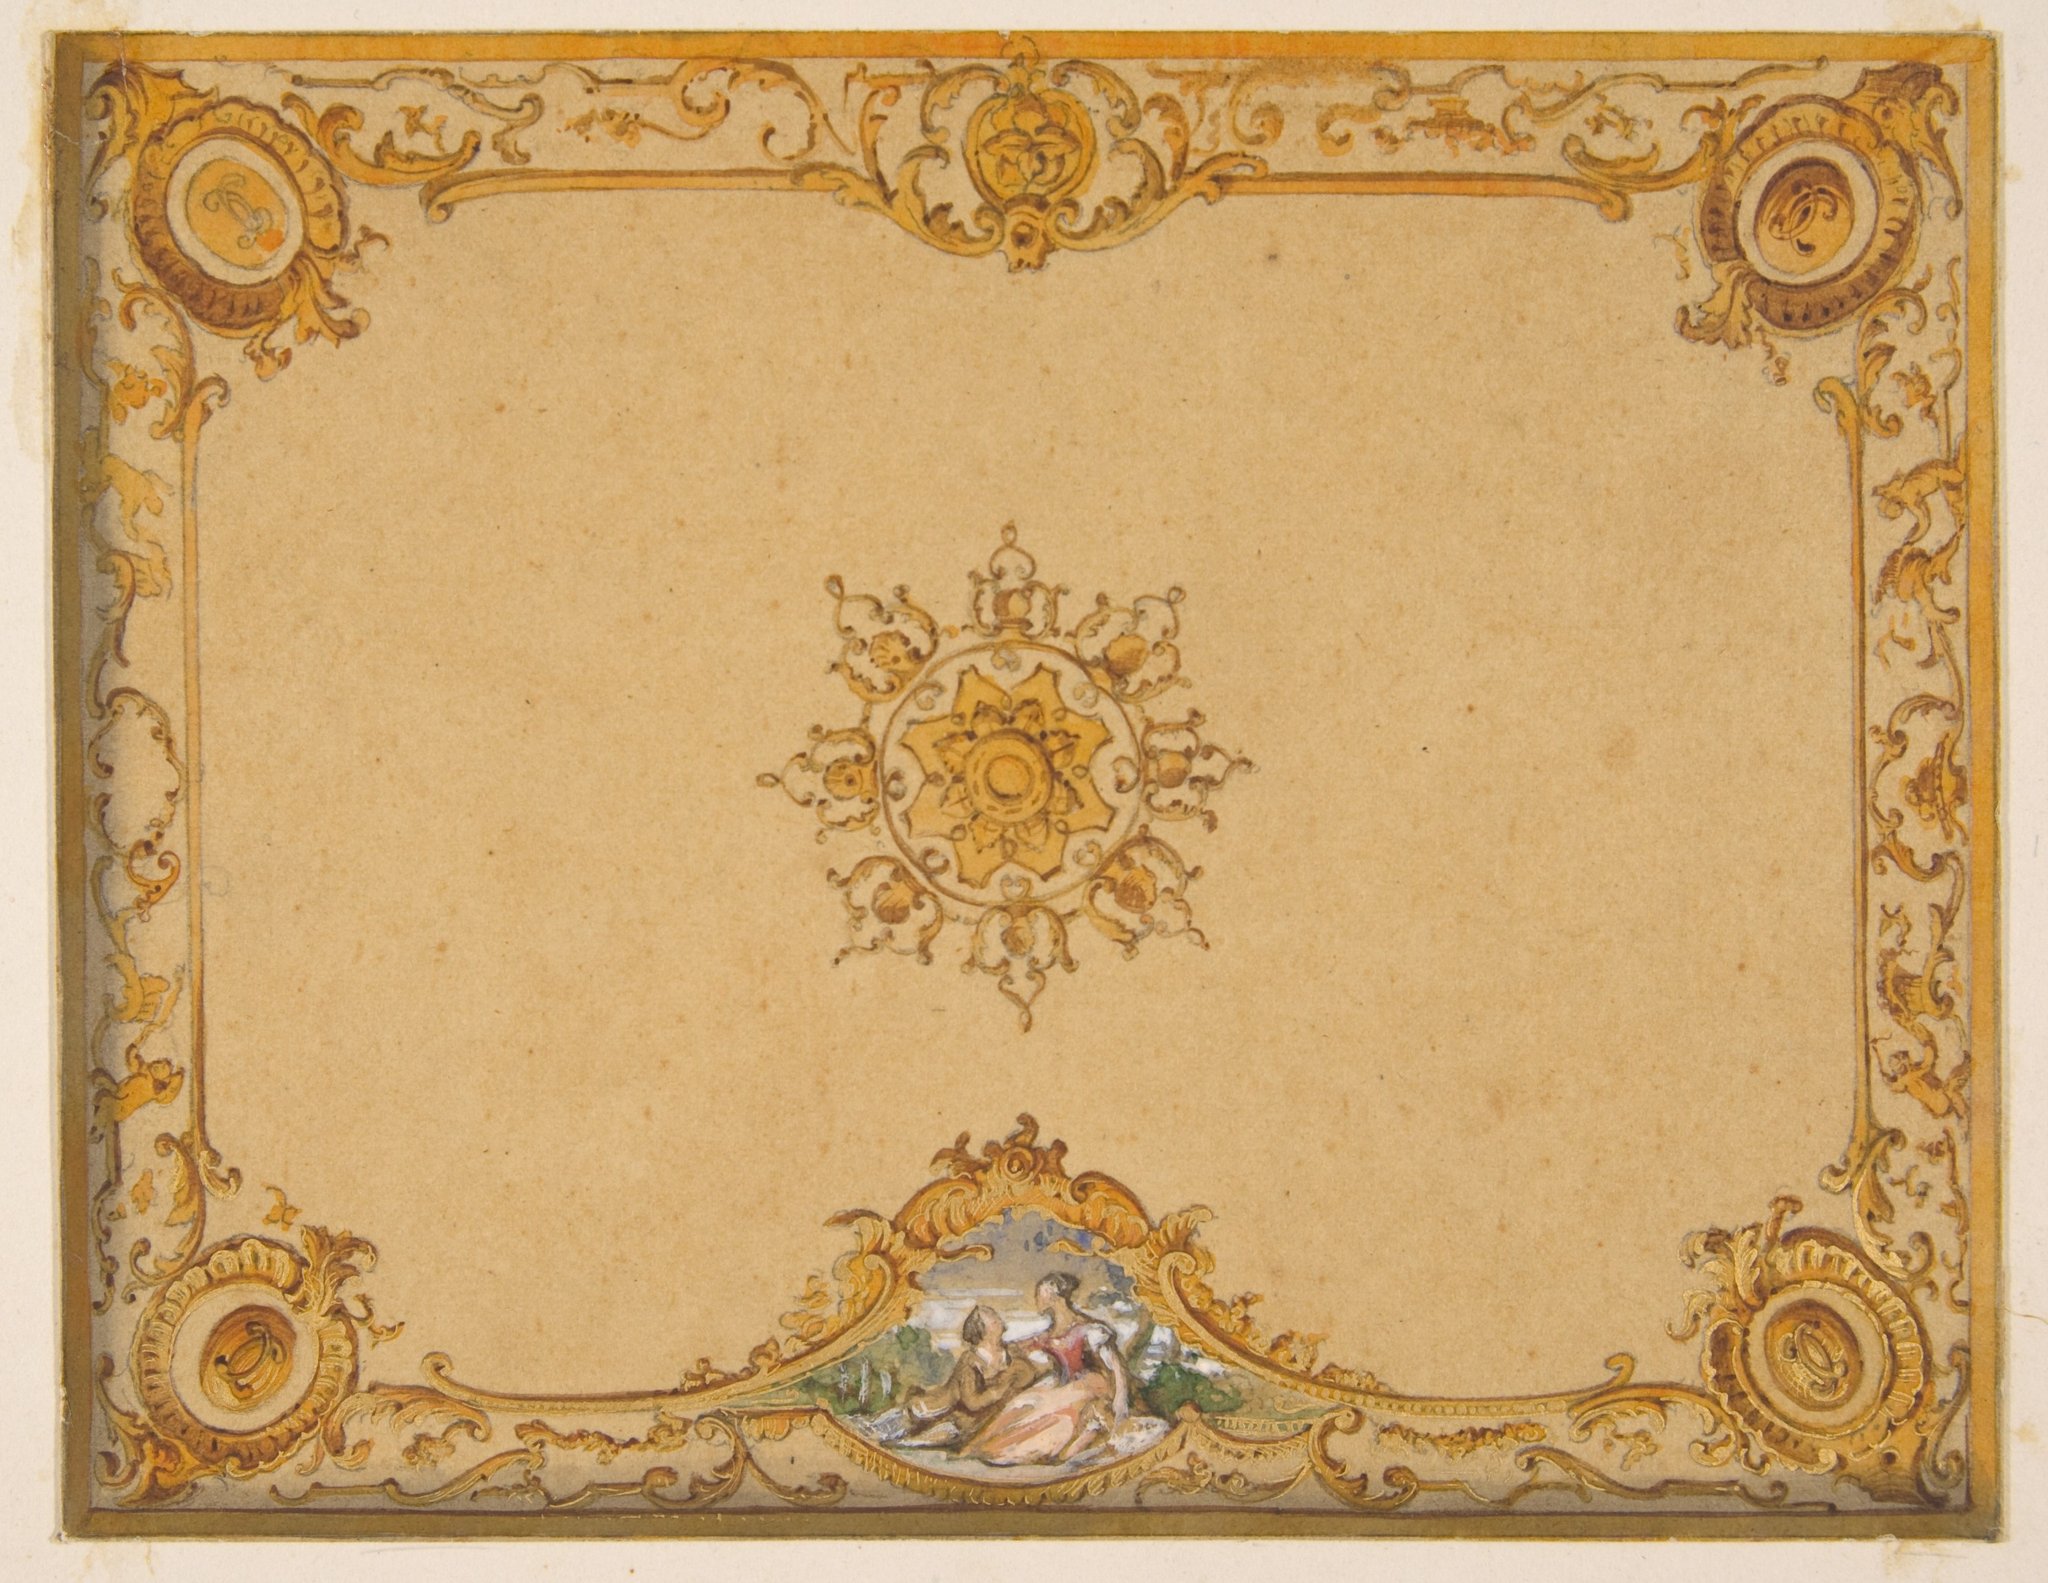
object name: drawing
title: Design for a ceiling with painted decoration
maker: jules-edmond-charles lachaise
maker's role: artist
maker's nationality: french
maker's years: 1897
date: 1830-1897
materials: gold paint, graphite, watercolor, paper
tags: men,women